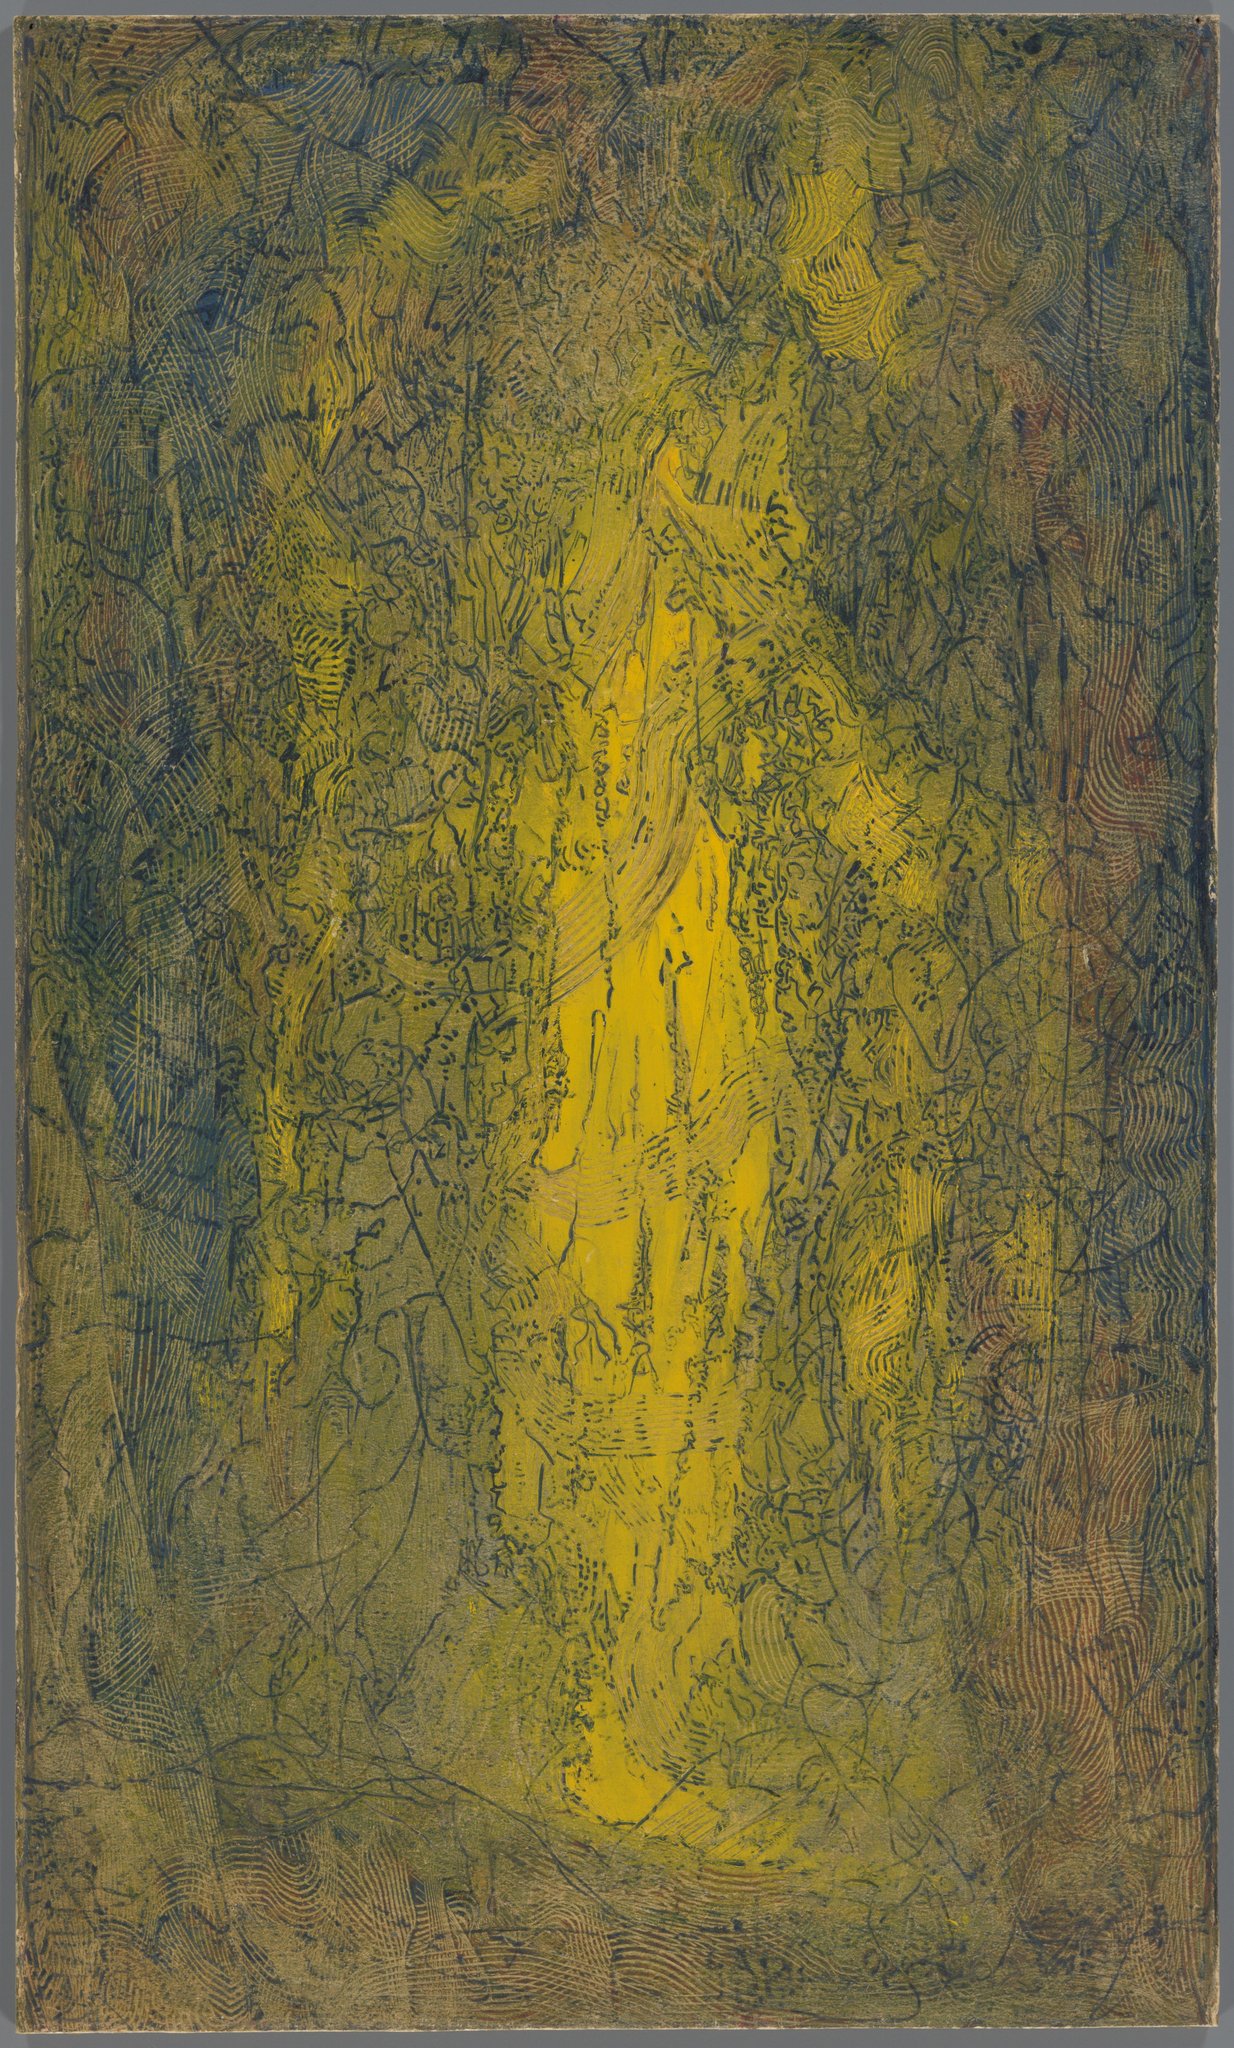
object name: drawing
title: Opus 862, Christus uit den dood herrezen wandelt droevig in den holen van 't bewustzijn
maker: albert plasschaert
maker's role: draughtsman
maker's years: 1866-1941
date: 1916-1927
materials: cardboard, chalk, oil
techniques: brush, scoring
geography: netherlands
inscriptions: title: ‘Opus 862 / Johannes Anjana Bestos Plasschaert / Christus uit den dood herrezen / wandelt droevig in de HOLEN / der bewust...’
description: Tentoongesteld in het Singer Museum Laren van 2014-05-29 t/m 2014-08-31. Amsterdam, Van Gogh Museum, Albert Plasschaert, februari 1990 (volgens veilingcatalogus, Christie’s 2002). Den Haag, Gemeentemuseum, Piet Mondriaan & Bart van der Leck. De uitvinding van een nieuwe kunst, Laren 1916-1918, 11 februari-21 mei 2017, no. 98, p. 74.